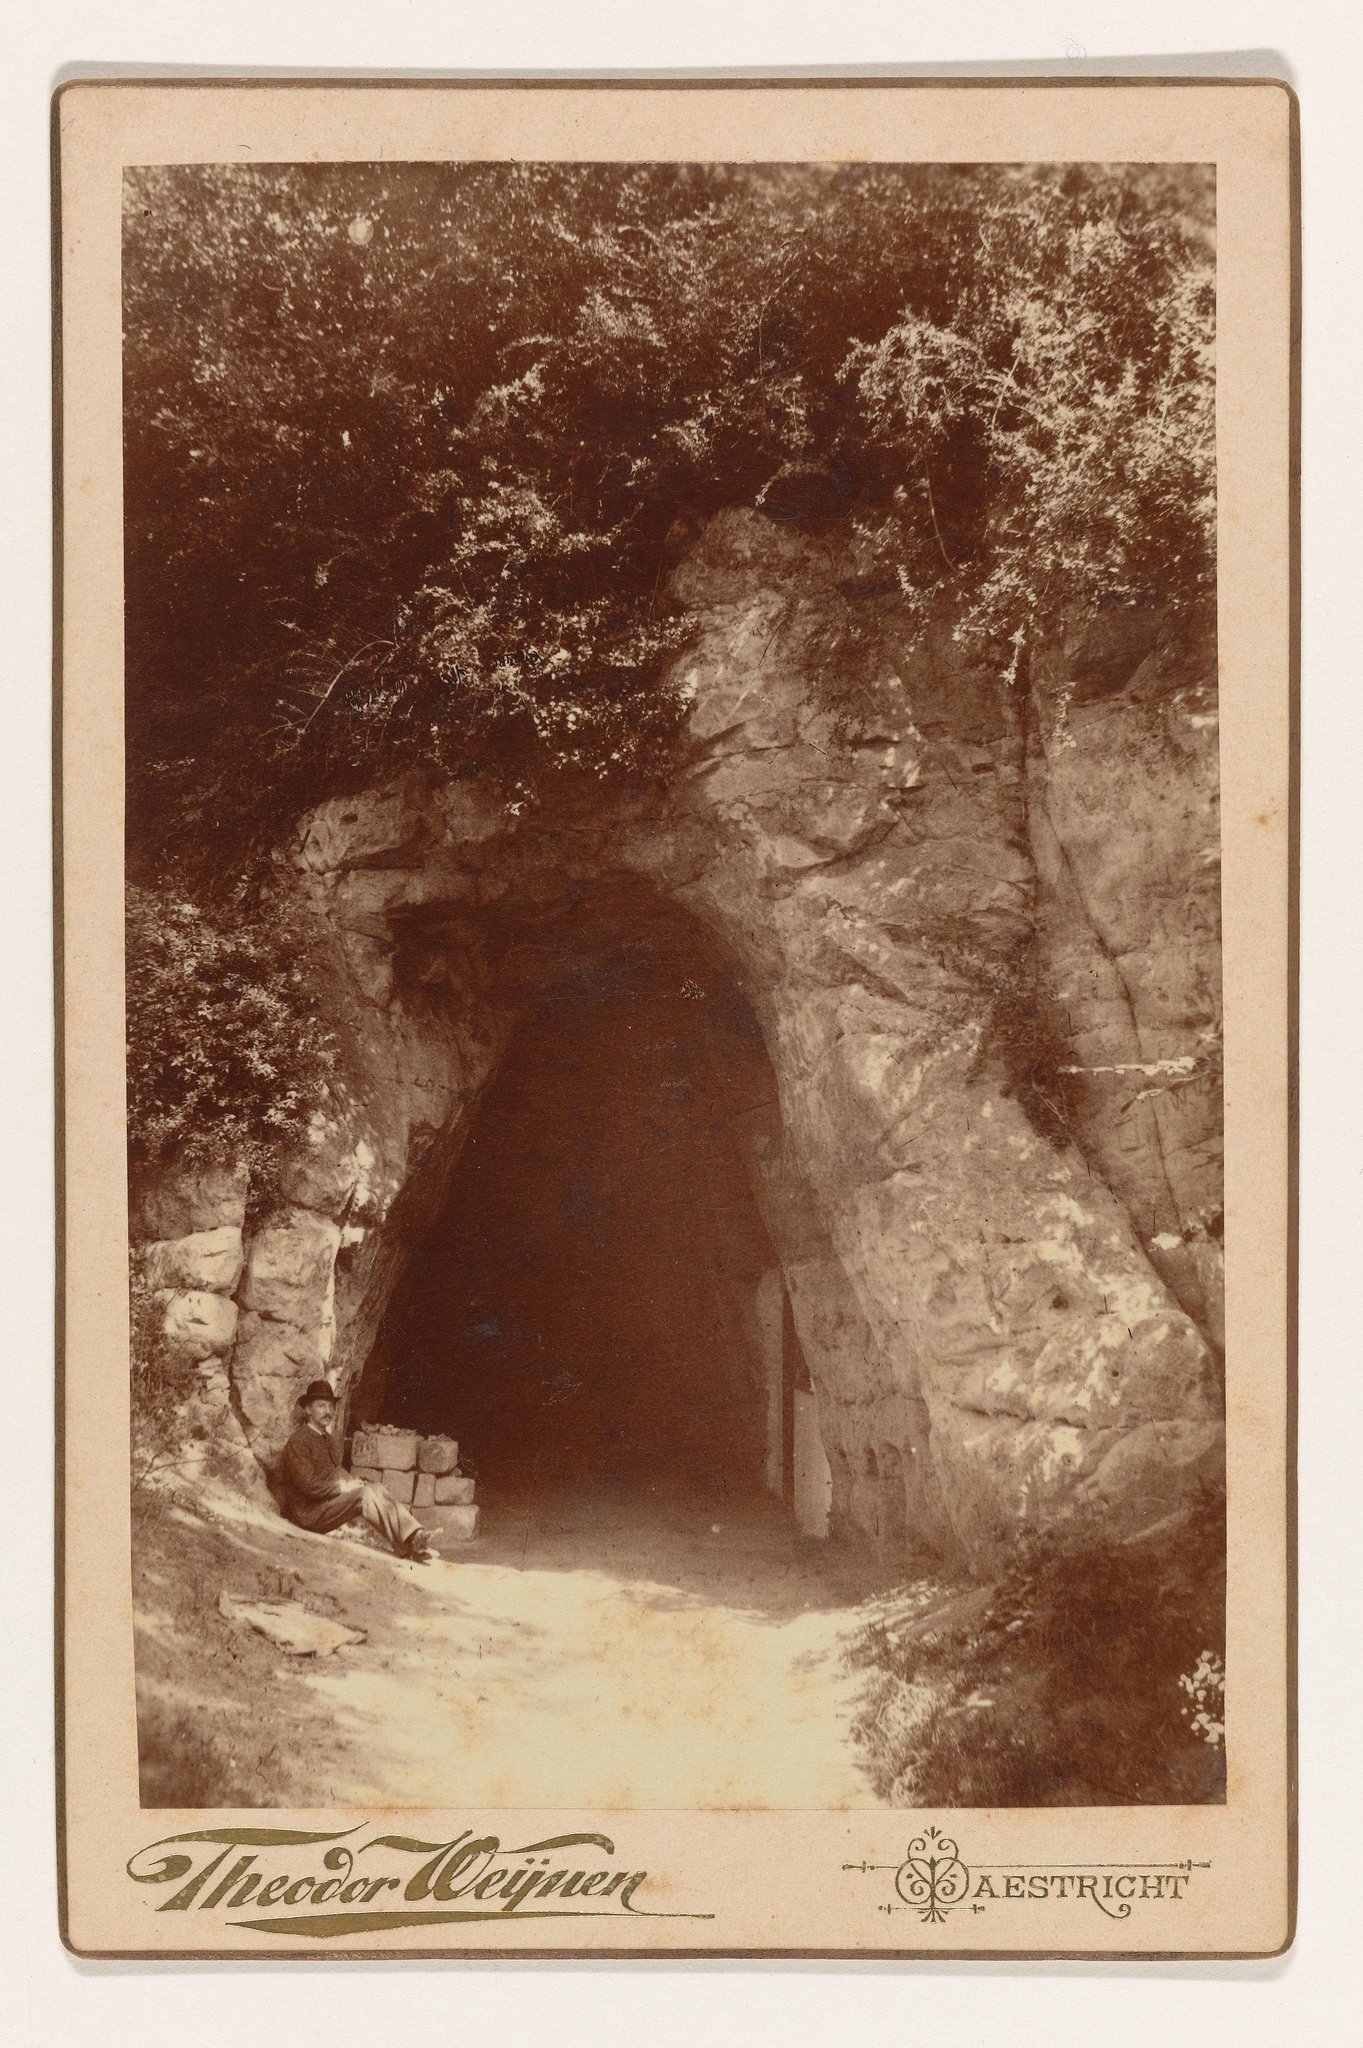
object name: photograph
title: Ingang van de Sint-Pietersberg nabij Maastricht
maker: théodor weijnen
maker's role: fotograaf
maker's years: 1835-1904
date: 1880-1900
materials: cardboard, photographic support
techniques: albumen print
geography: netherlands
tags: cave, grotto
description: Ingang van de Sint-Pietersberg nabij Maastricht. In de opening zit een man naast een stapel mergelblokken.